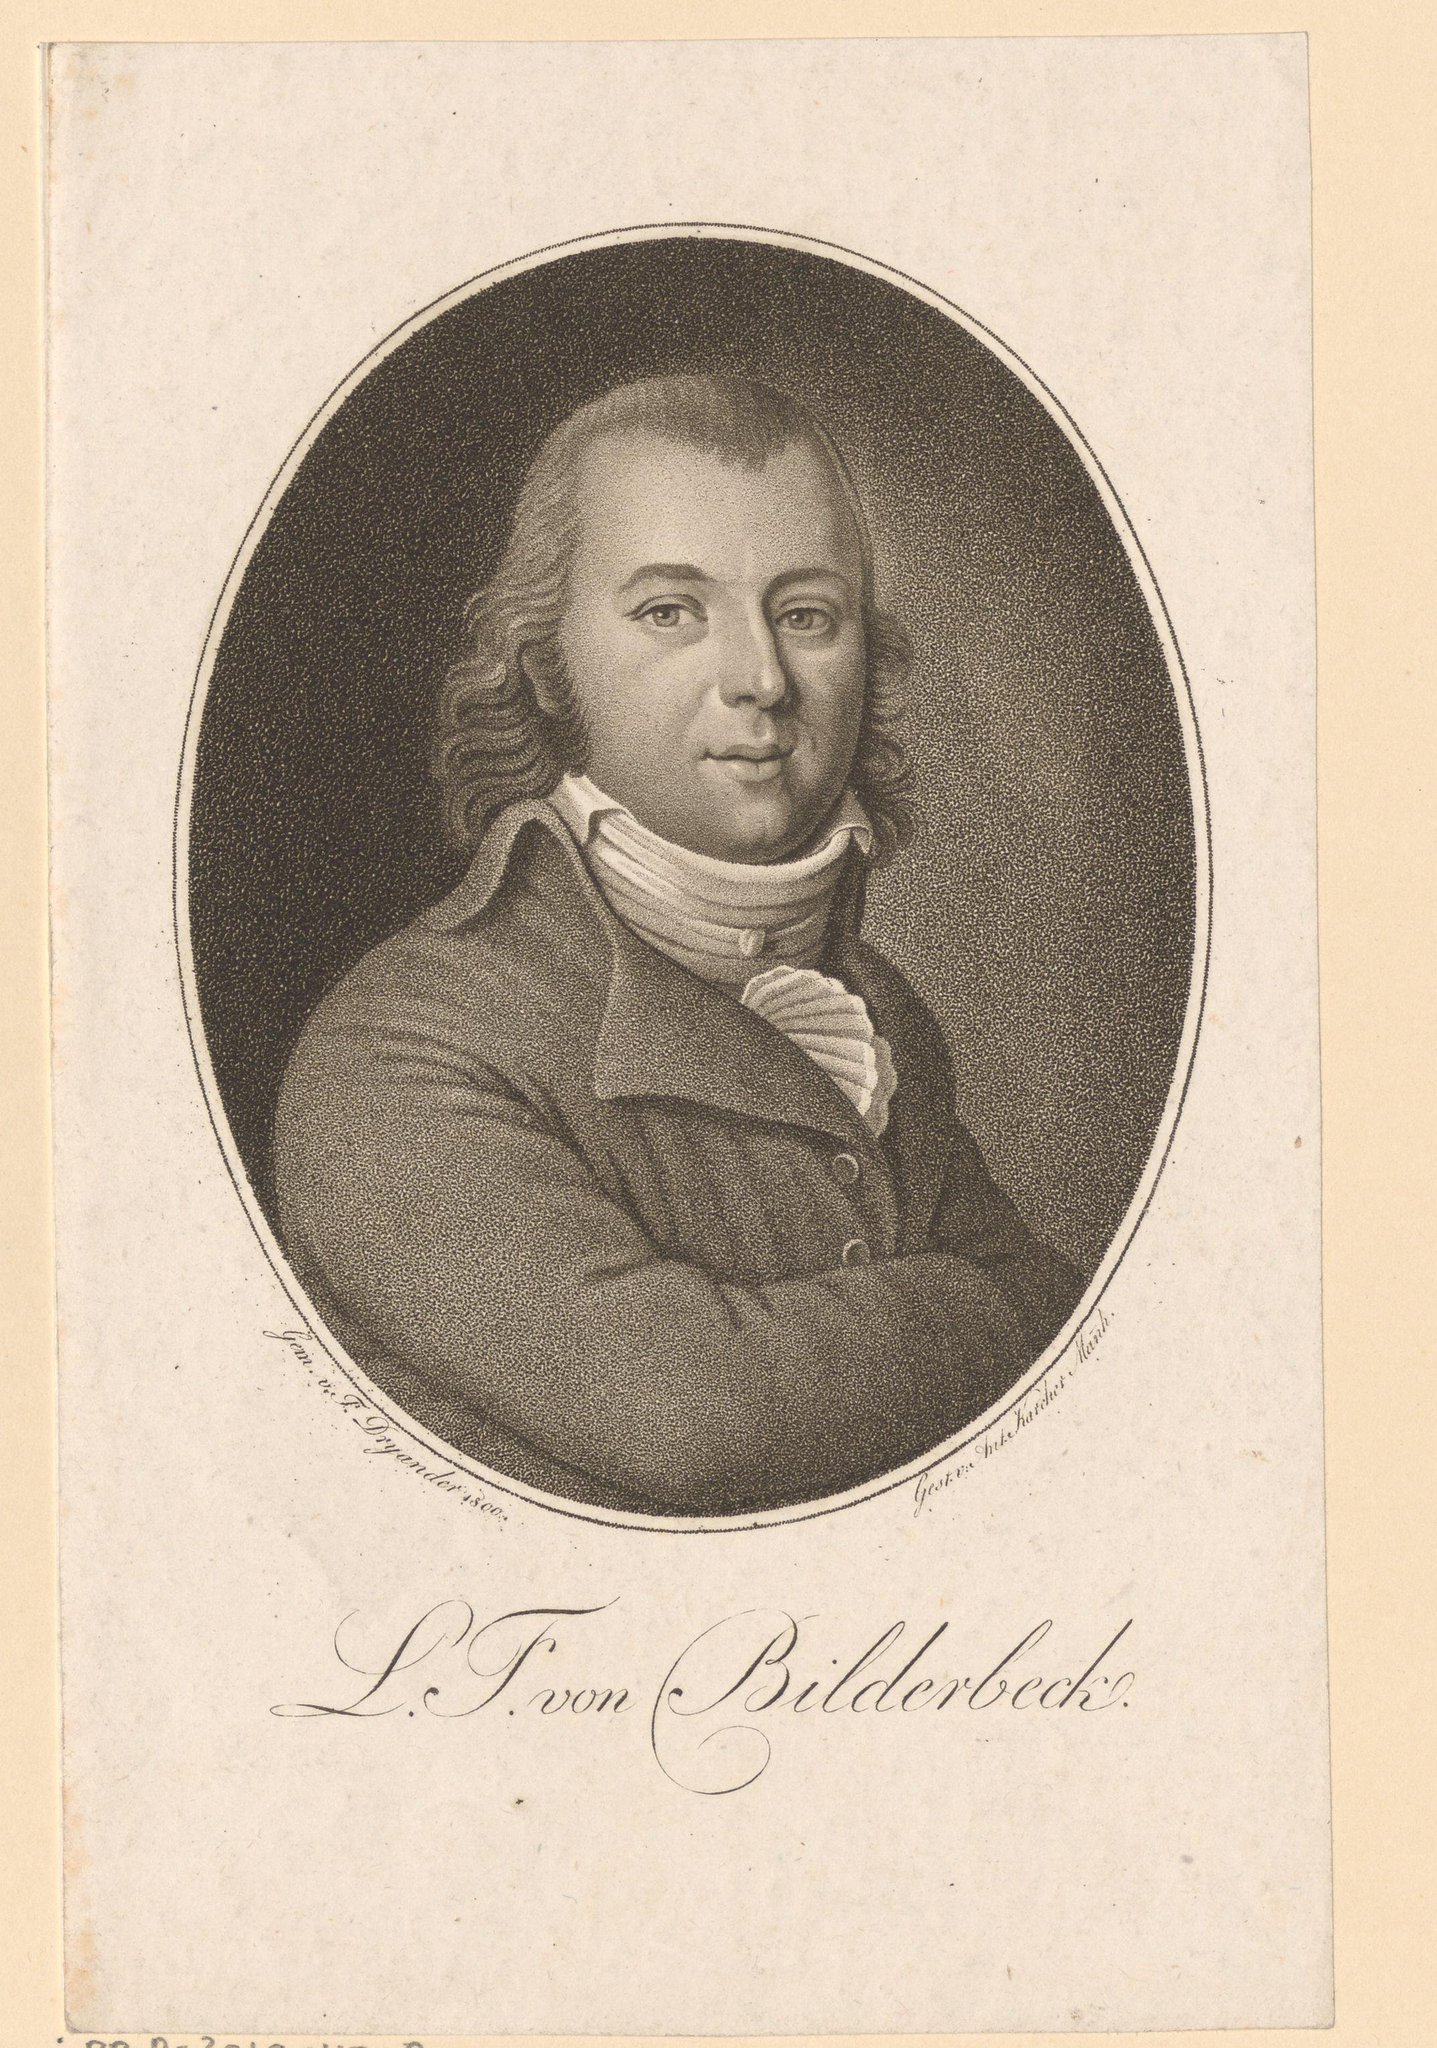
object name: print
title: Portret van Ludwig Franz von Bilderbeck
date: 1800-1842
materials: paper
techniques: etching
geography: mannheim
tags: paris, historical persons, portrait of a writer